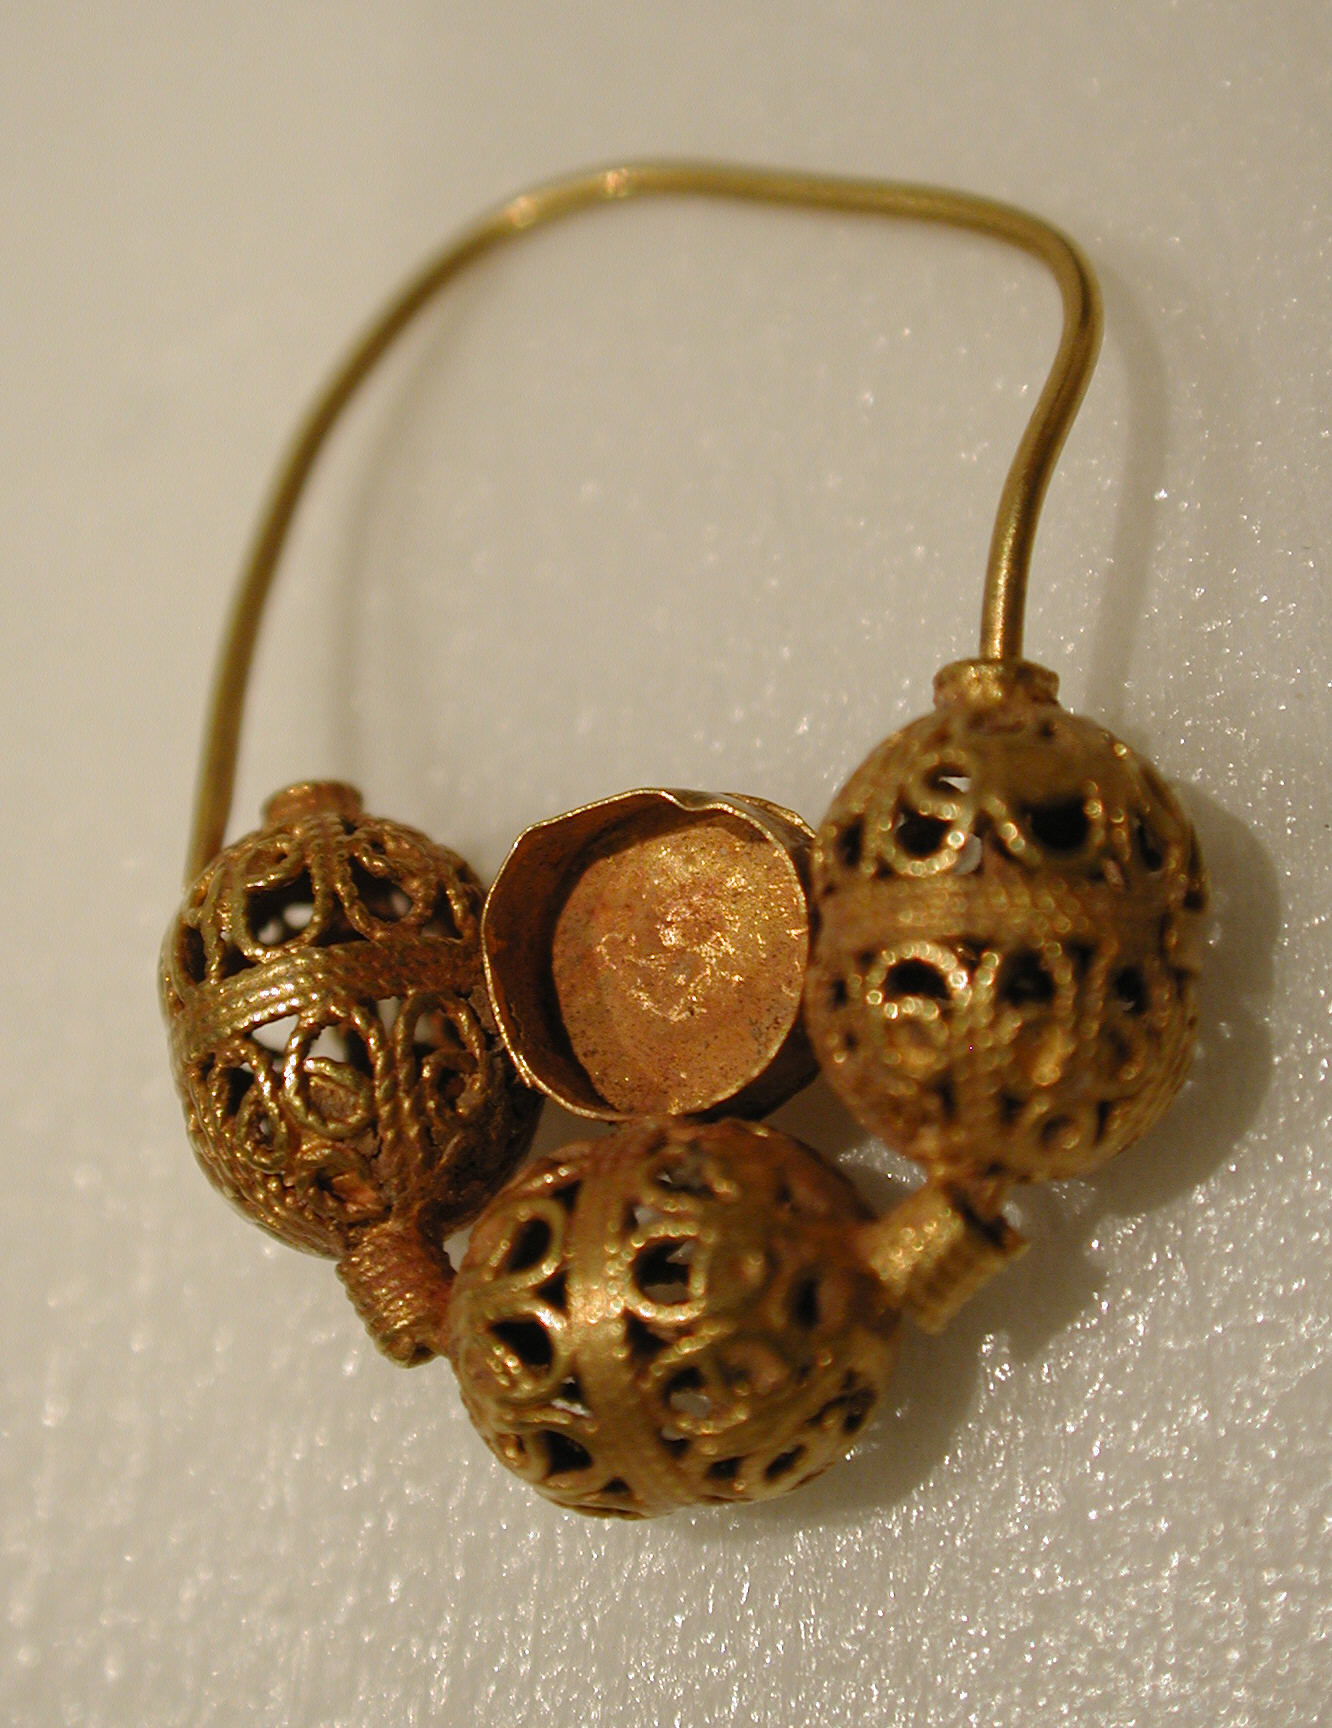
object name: earring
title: Earring, One of a Pair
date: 1101-1300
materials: gold, metal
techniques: filigree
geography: iran